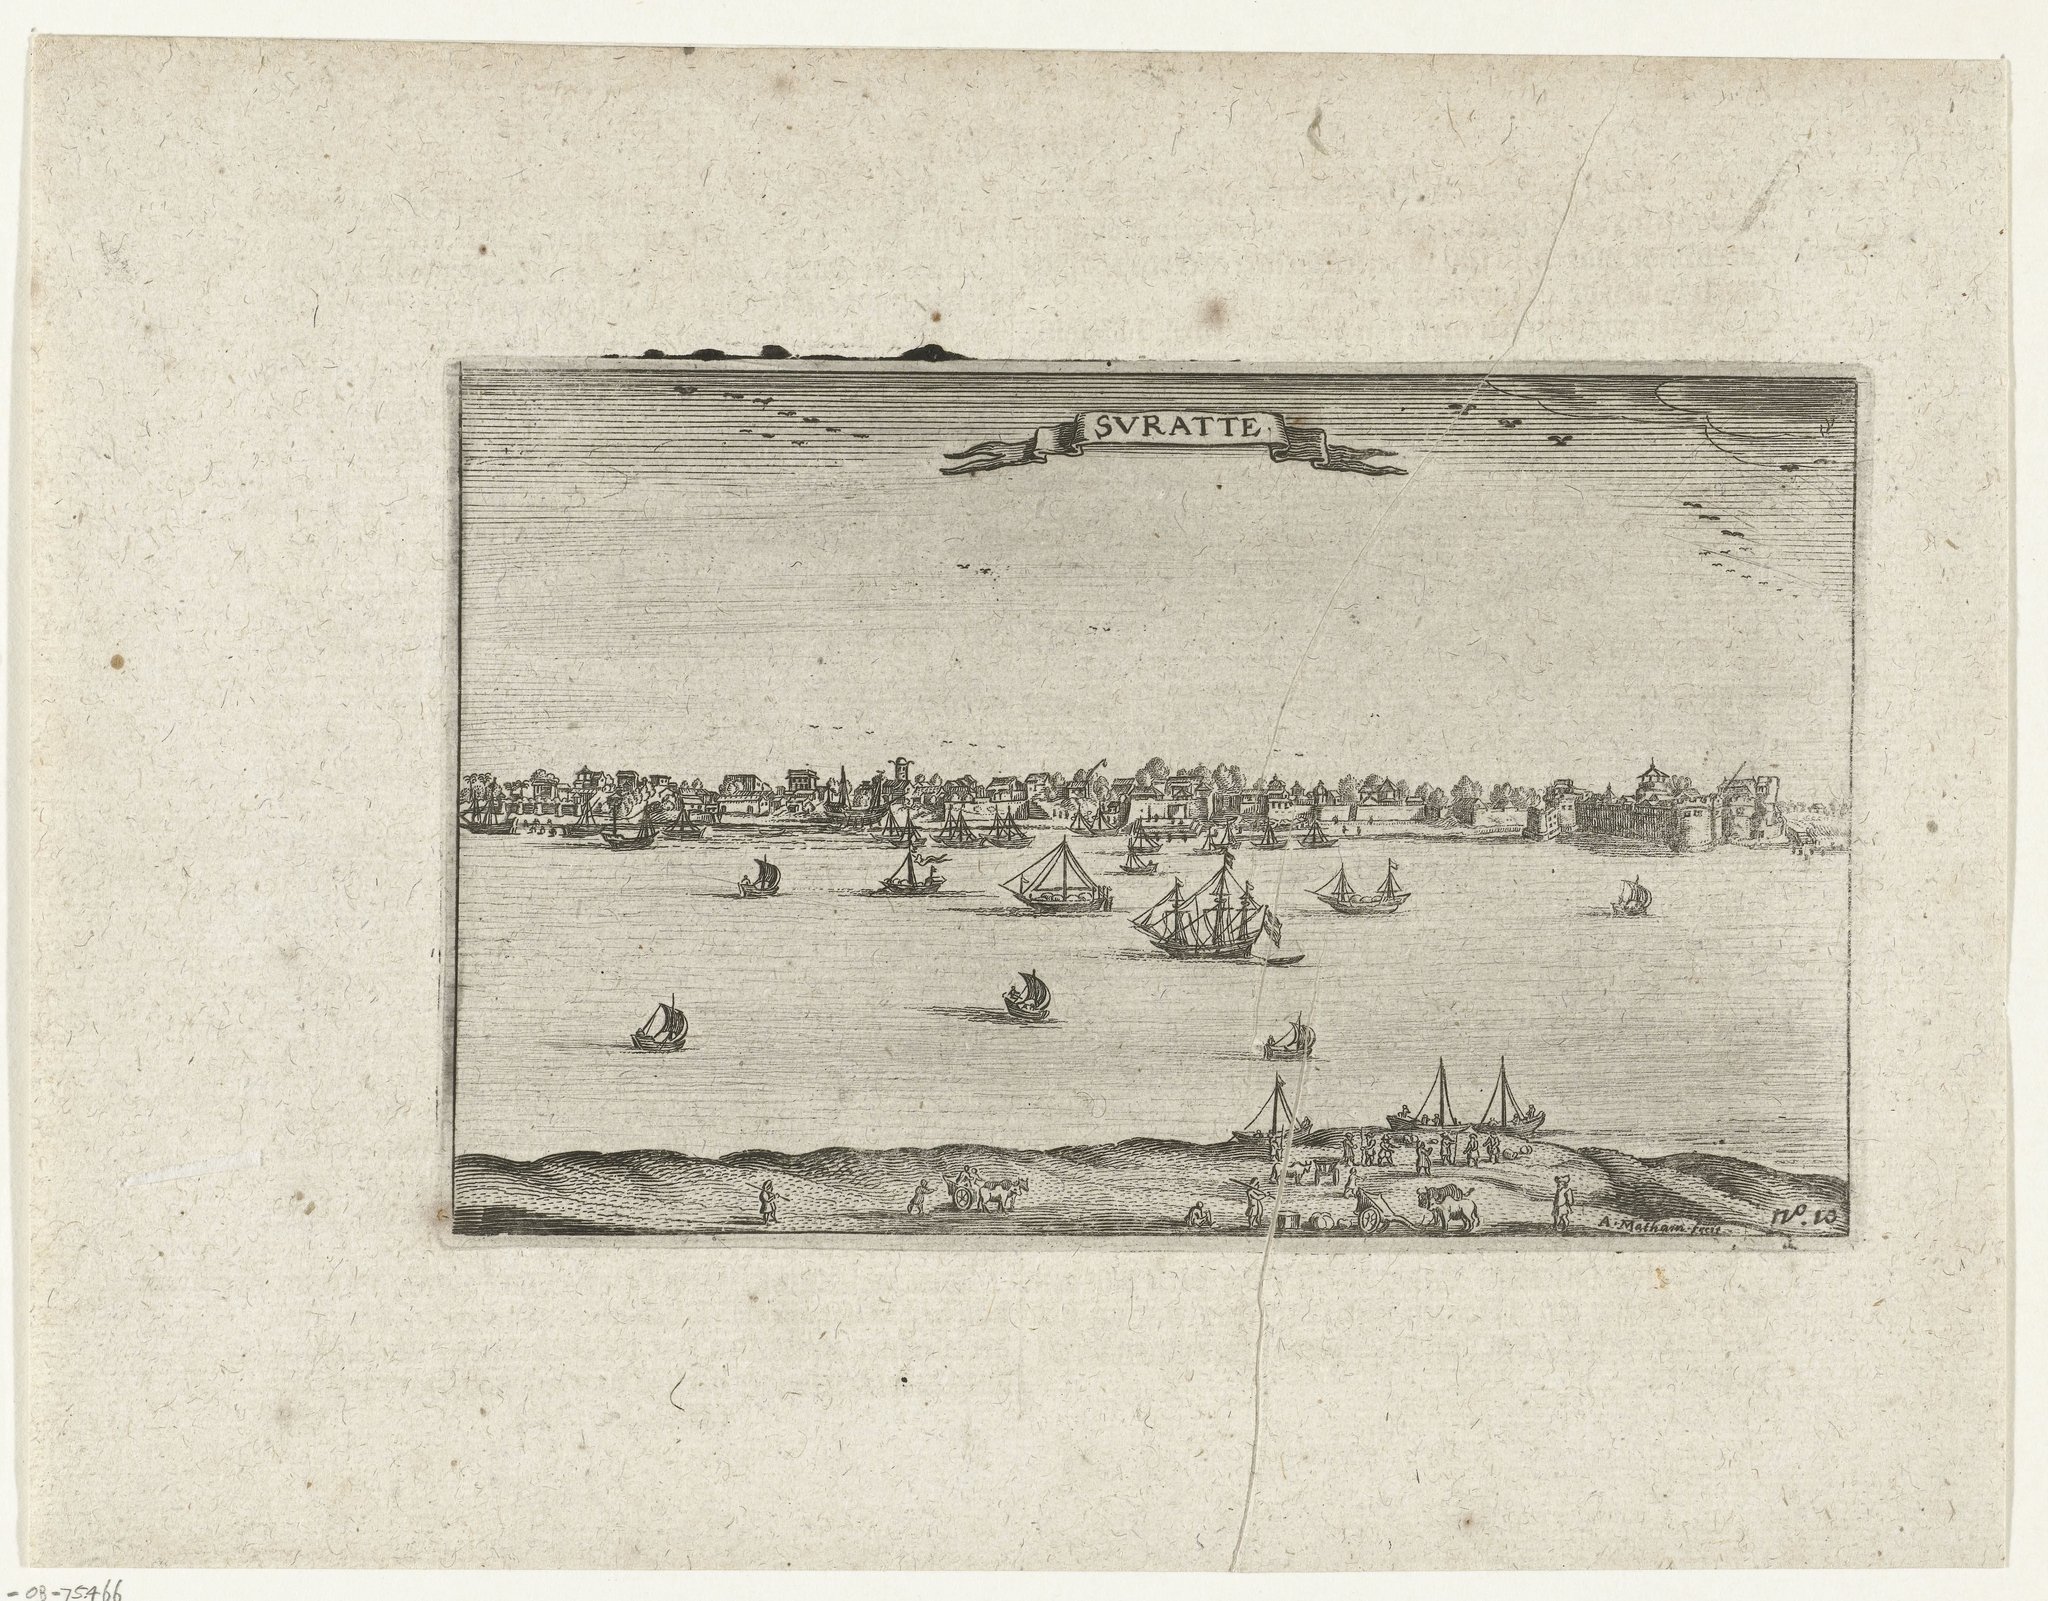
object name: print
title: De vermaerde Stadt Suratte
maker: adriaen matham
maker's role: draughtsman, print maker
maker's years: 1599-1660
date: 1632-1634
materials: paper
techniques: engraving, etching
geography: northern netherlands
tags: antwerp, pieter van den broecke, landscapes in tropical and sub-tropical regions, exploration, expedition, voyage of discovery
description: Gebruikt als illustratie eerst in: P. van den Broecke, Korte historiael ende journaelsche aenteyckeninghe, van al 'tgheen merck-waerdich voorgevallen is, in de langhduerighe reysen, soo nae Cabo Verde, Angola, &c. als insonderheydt van Oost-Indien, Hans Passchiers van Wesbusch, Haarlem, 1634. In deze staat gebruikt in : I. Commelin, Begin ende voortgangh, van de Vereenighde Nederlantsche Geoctroyeerde Oost-Indische Compagnie, J. Janssonius, Amsterdam 1646. Genummerd: No. 10.